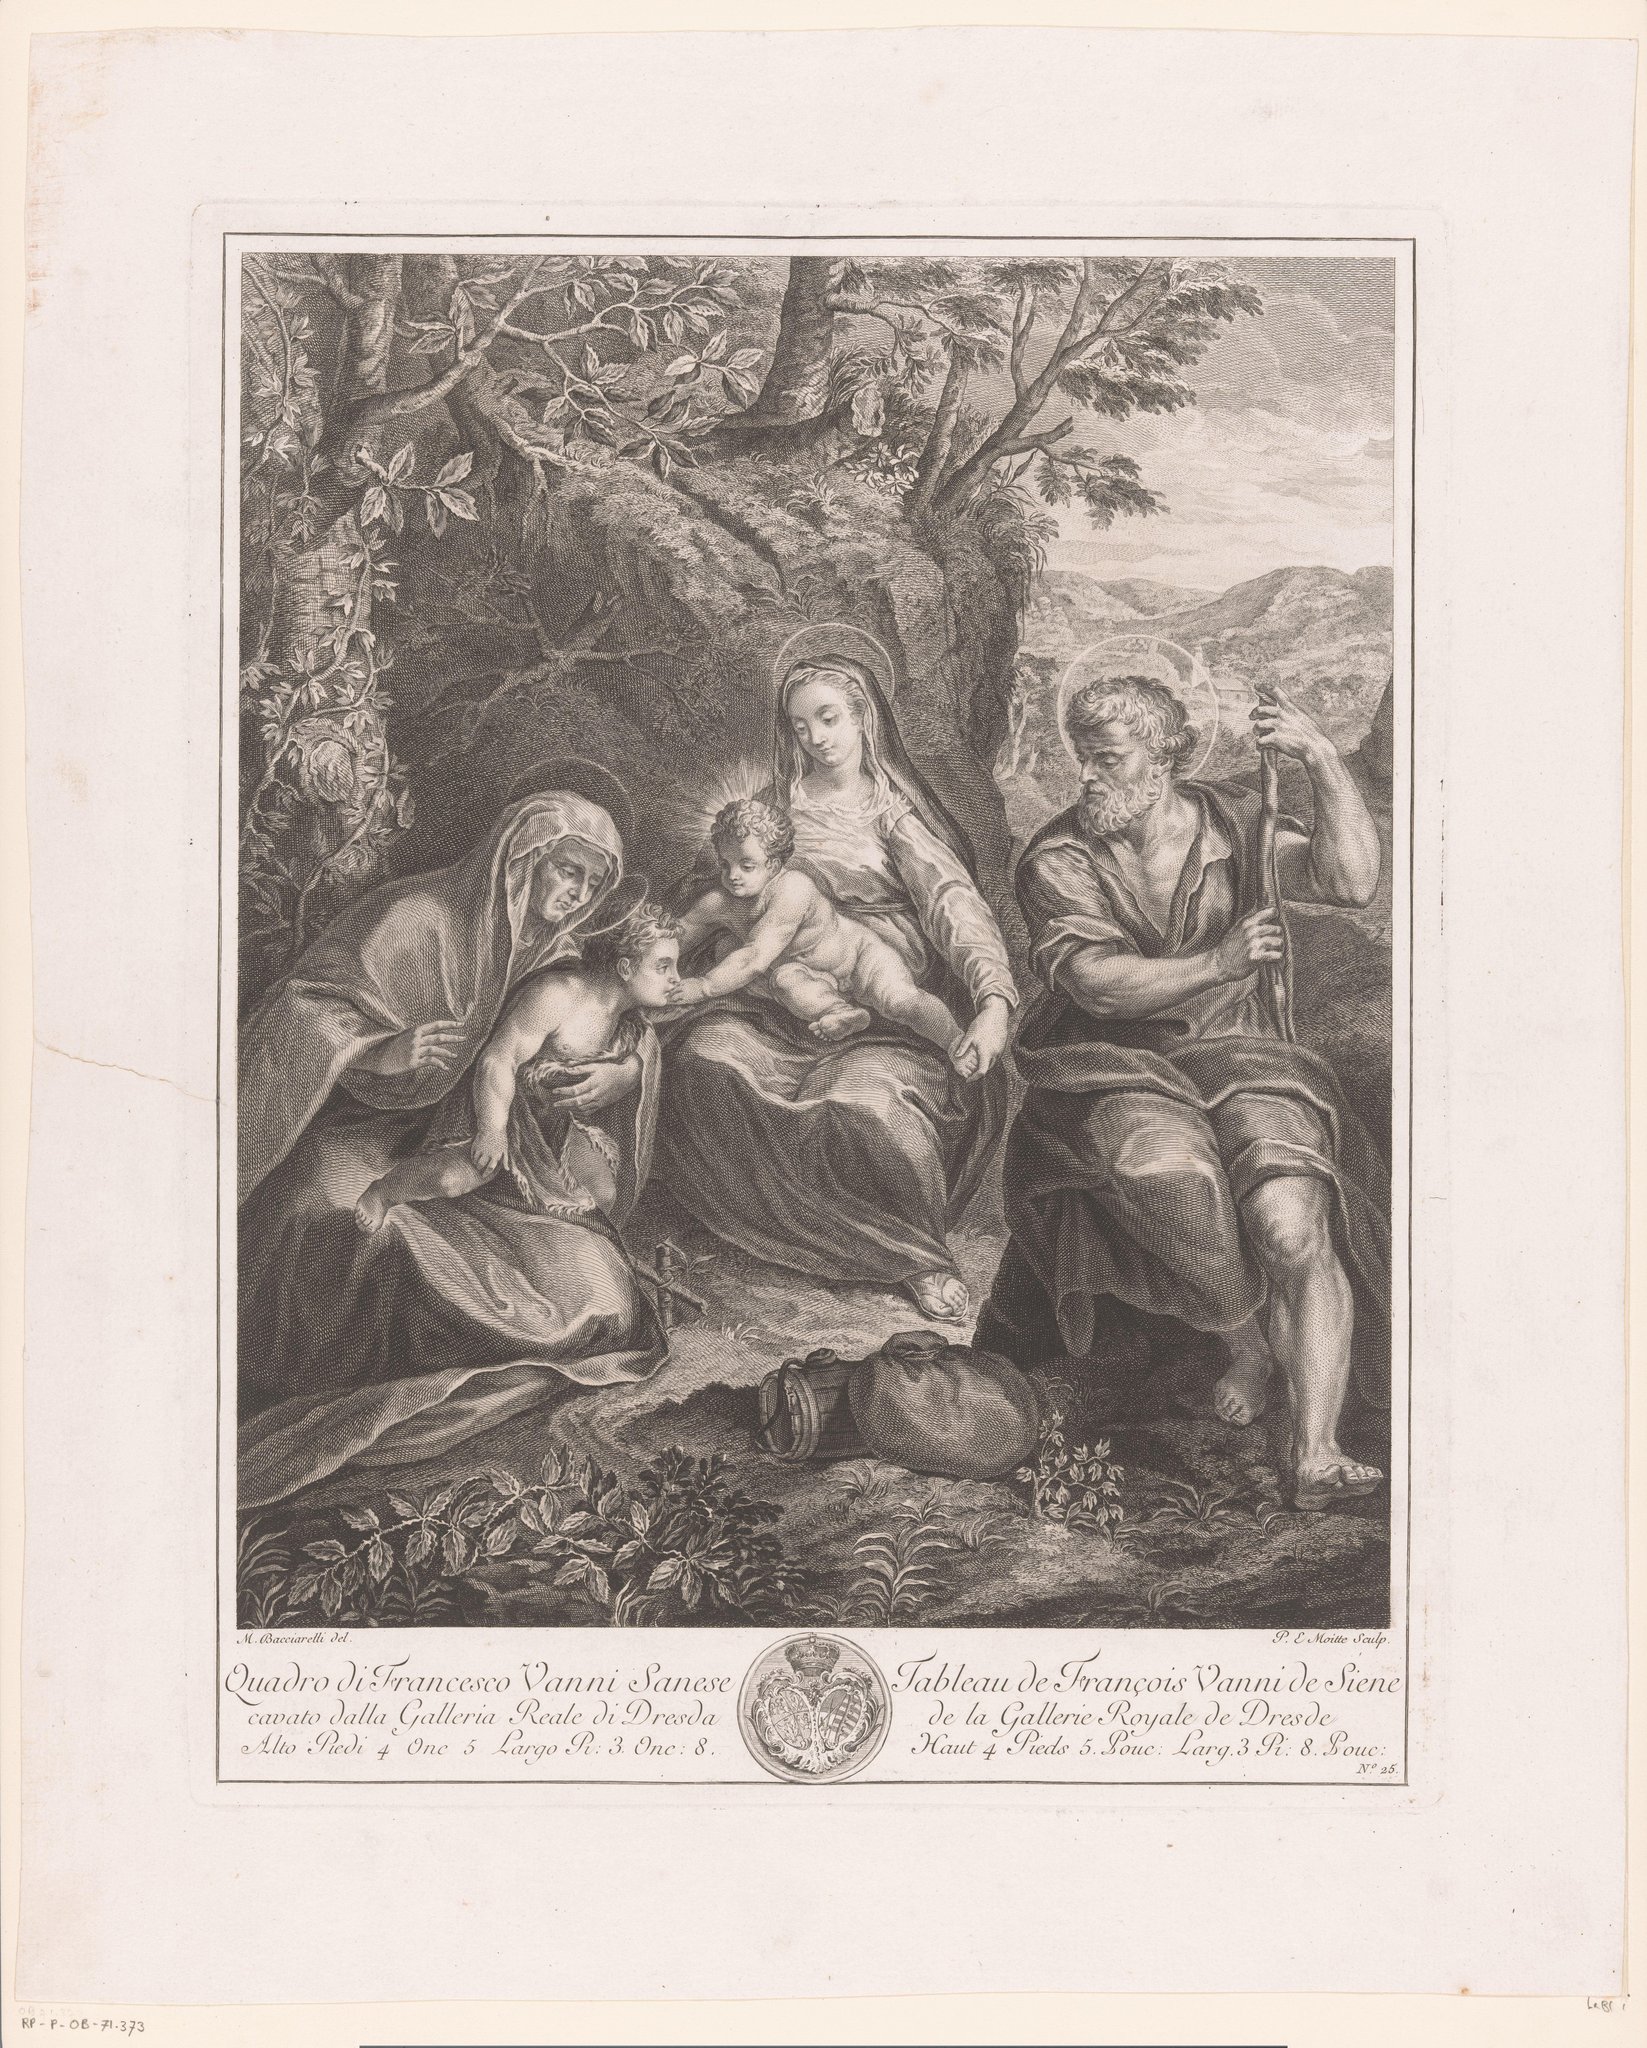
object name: print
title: Schilderijen in de koninklijke kunstcollecties te Dresden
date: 1753-1757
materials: paper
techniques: engraving, etching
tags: holy family, and derived representations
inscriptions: collector's mark: Lugt 2228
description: Prent afkomstig uit de 'Recueil d'estampes d'après les plus célèbres tableaux de la Galerie Royale de Dresde', verschenen in twee delen in 1753 en 1757, met in totaal 100 prenten naar schilderijen in de koninklijke kunstcollecties te Dresden.